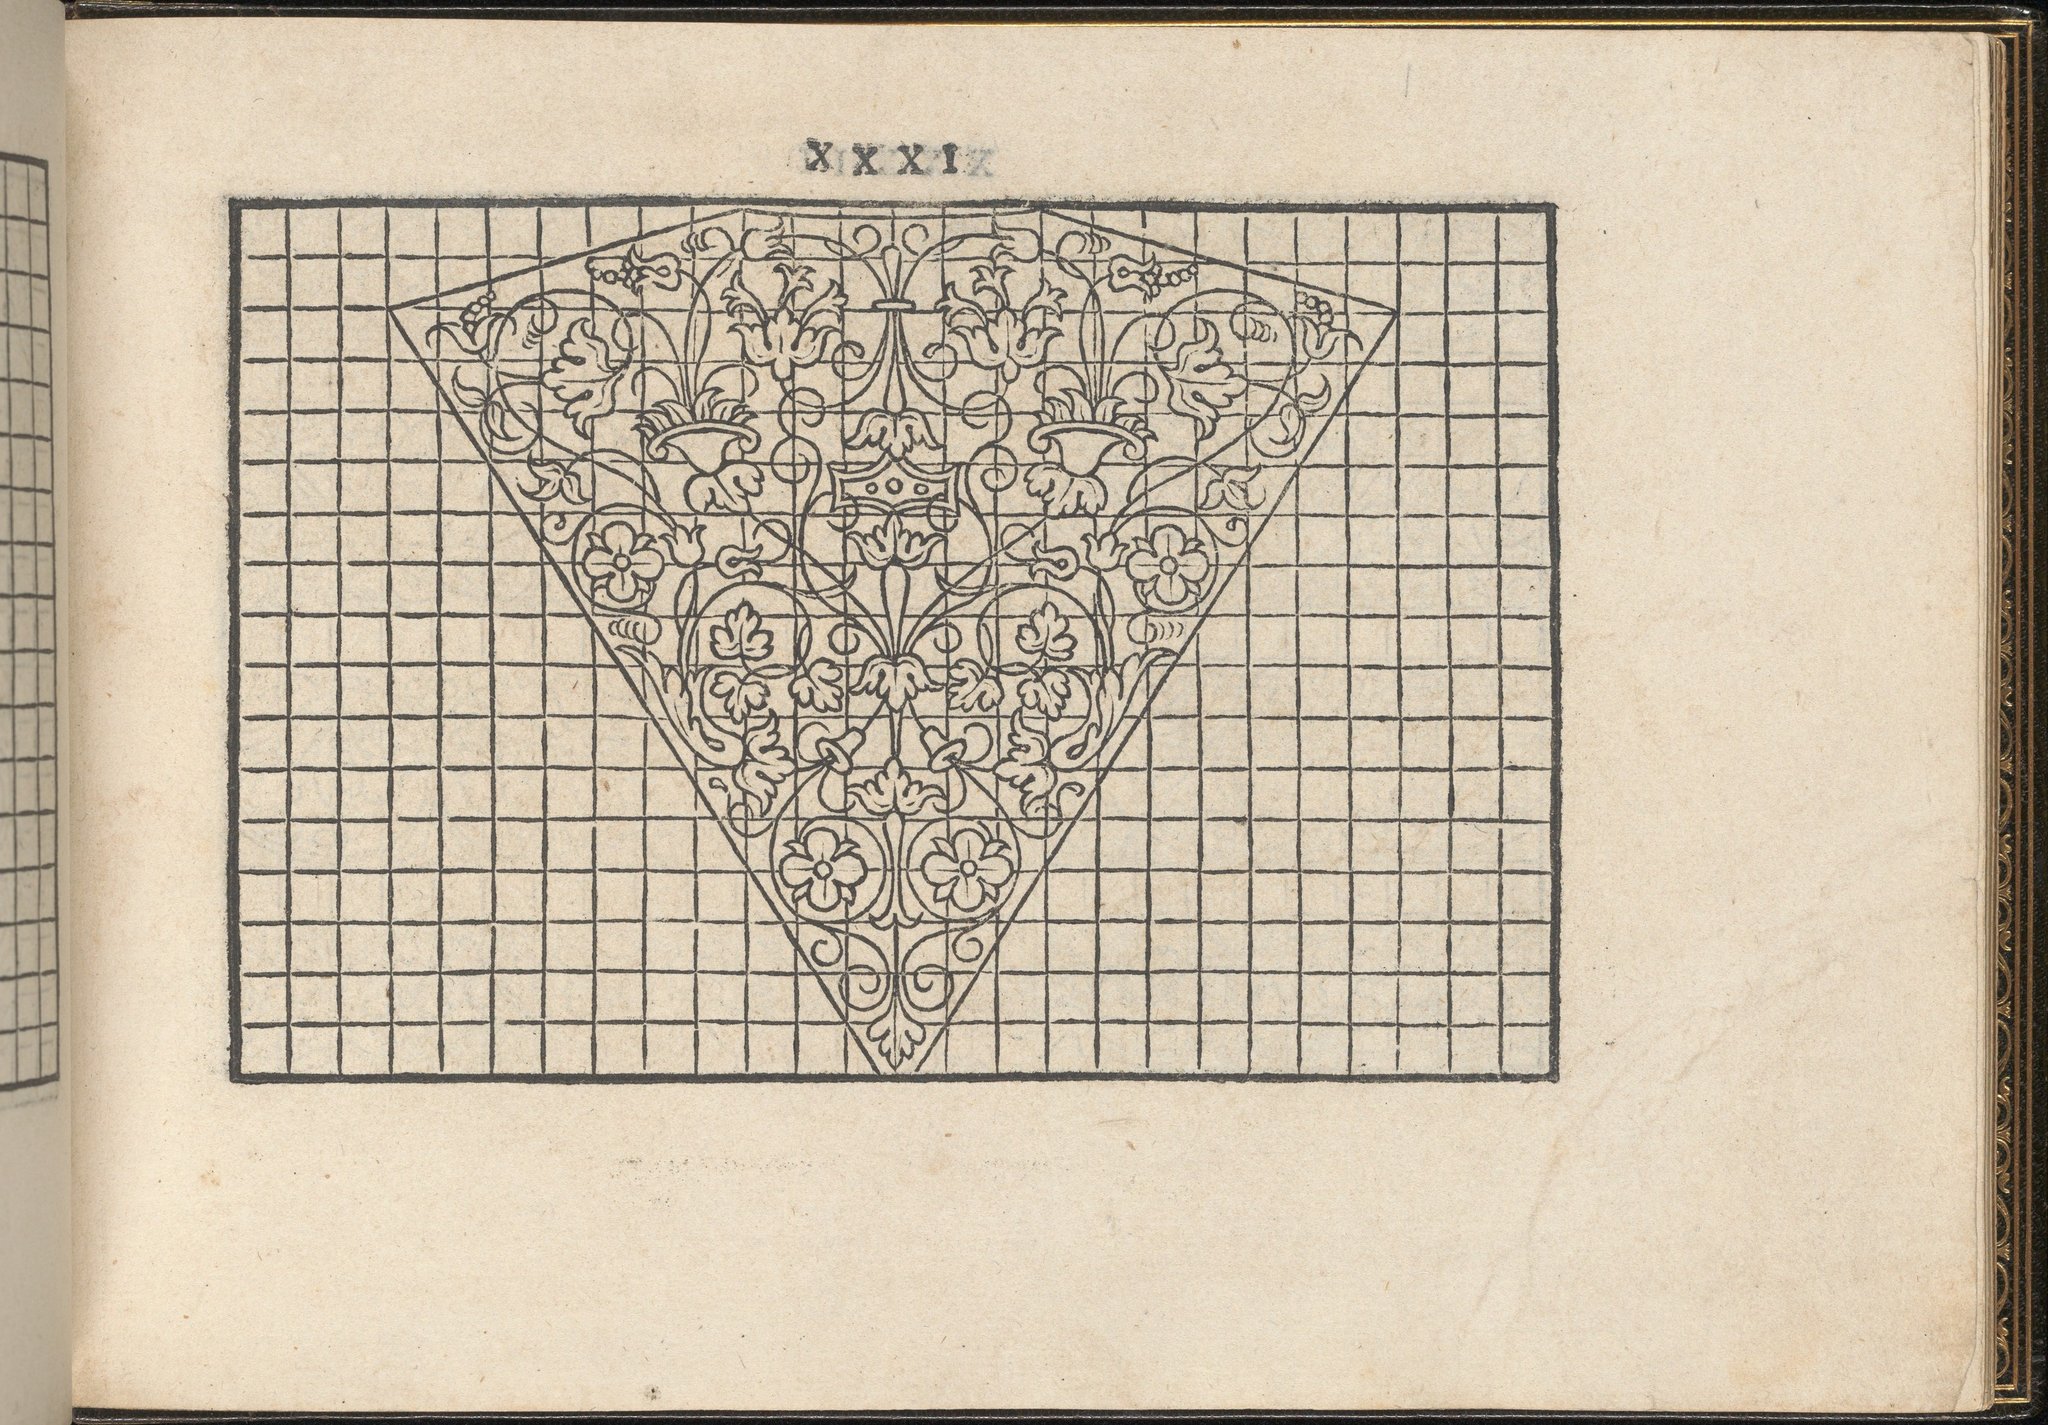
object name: book print ornament architecture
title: La Vera Perfettione del Disegno di varie sorti di recami, page 16 (recto)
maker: giovanni ostaus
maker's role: publisher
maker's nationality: italian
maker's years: 1507-1607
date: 1567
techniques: woodcut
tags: ornament